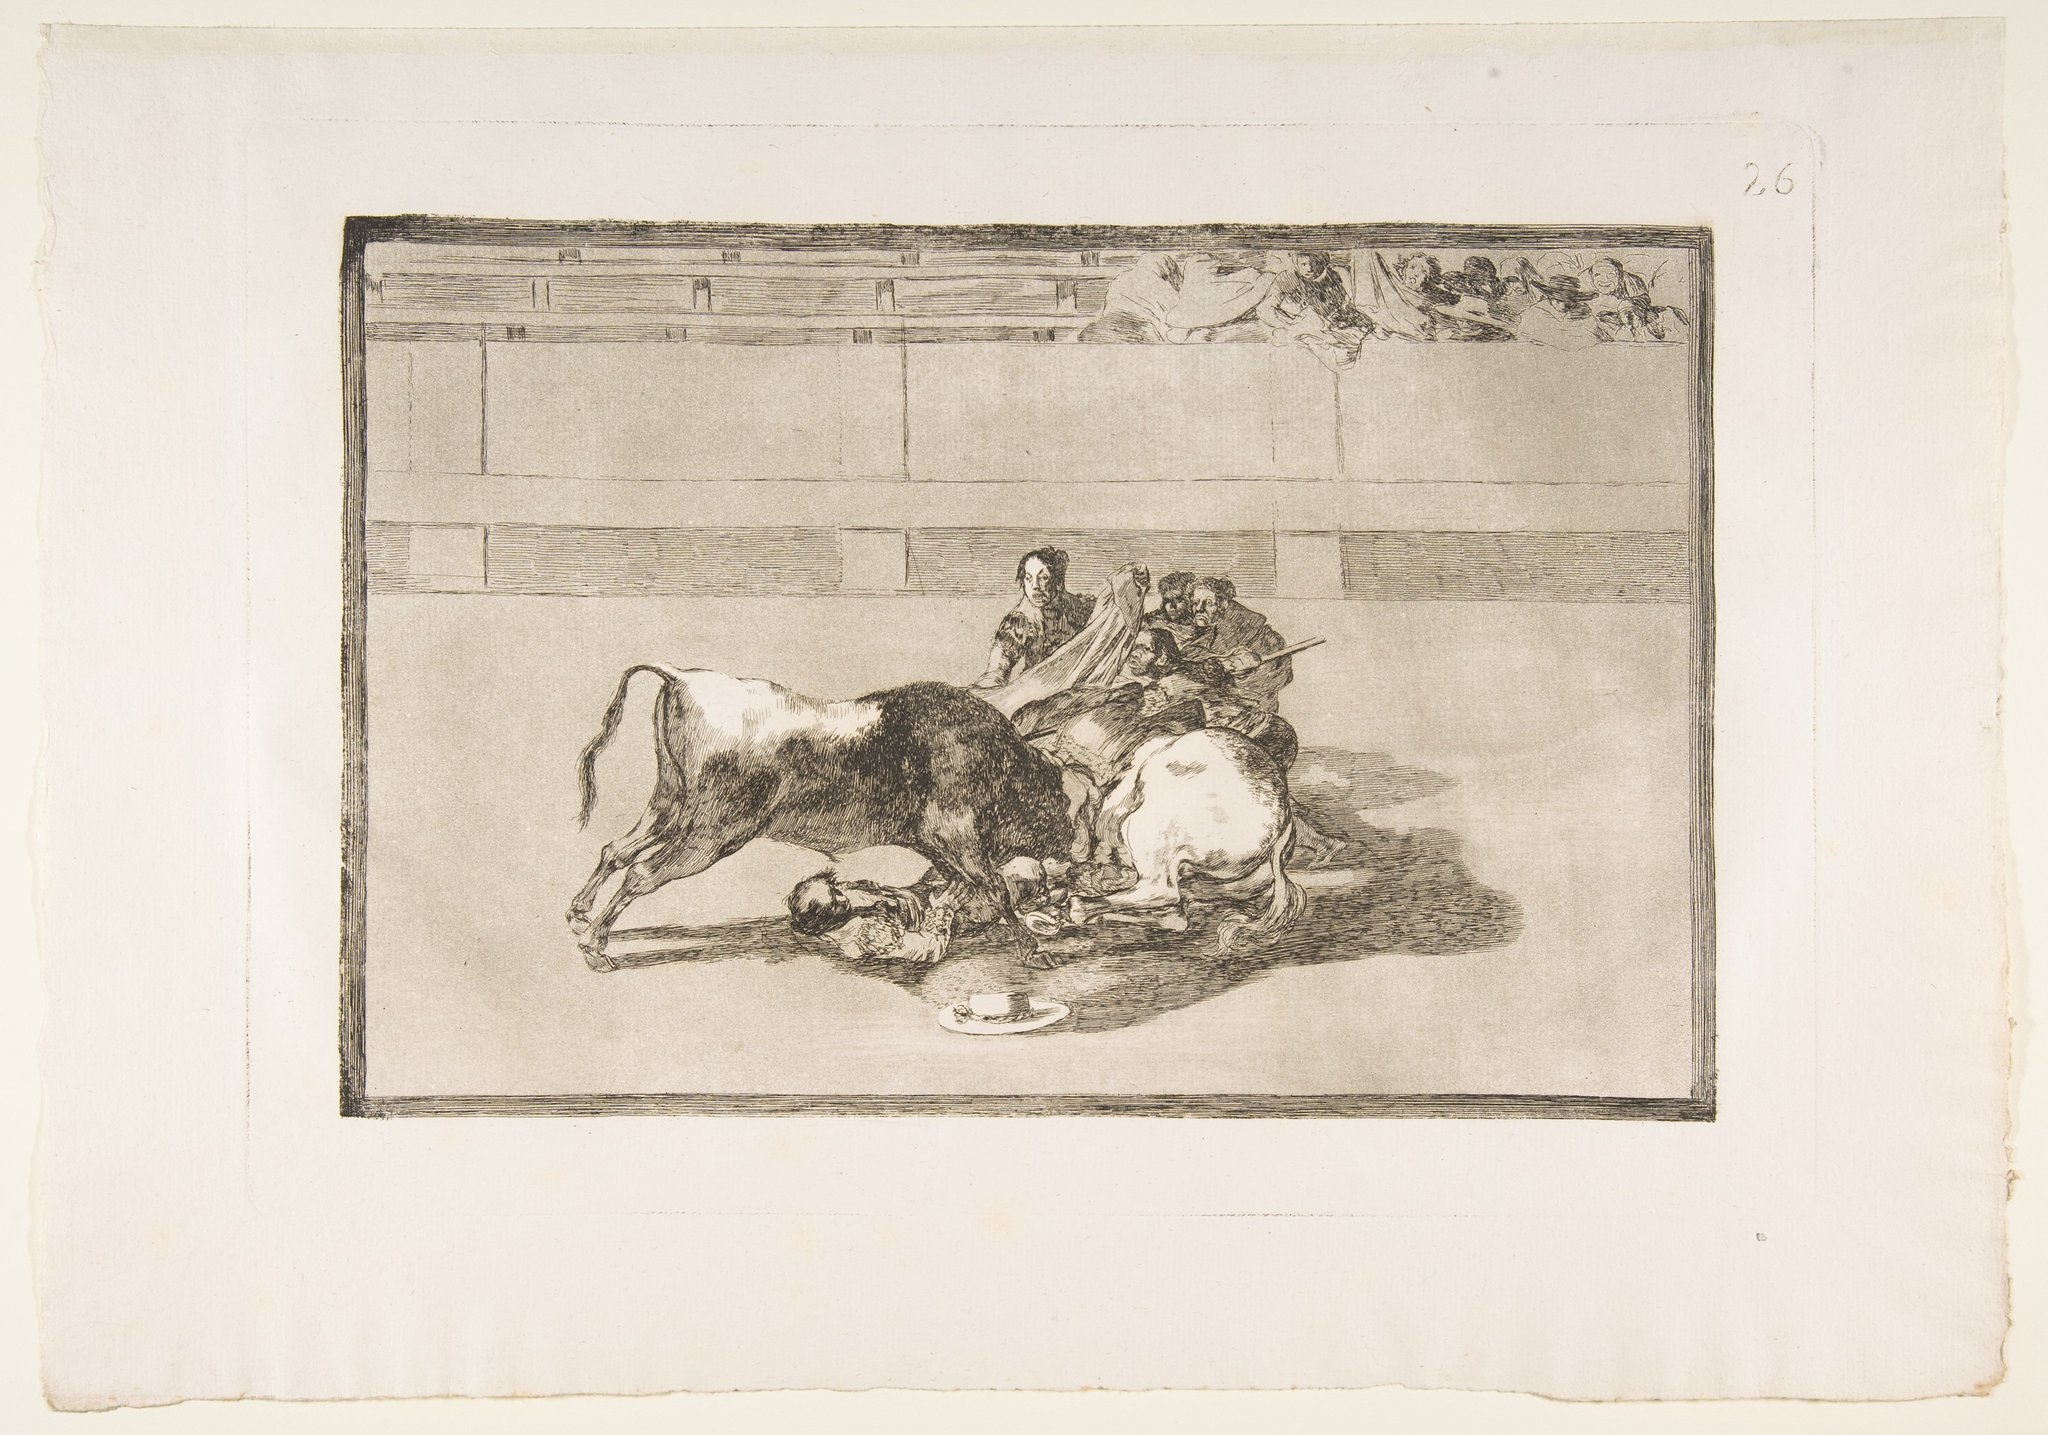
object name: print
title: Plate 26 from "La Tauromaquia": A picador is unhorsed and falls under the bull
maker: goya (francisco de goya y lucientes)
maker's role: artist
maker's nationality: spanish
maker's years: 1746-1828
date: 1816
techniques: aquatint, burnishing, drypoint, etching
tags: men,bulls,horses